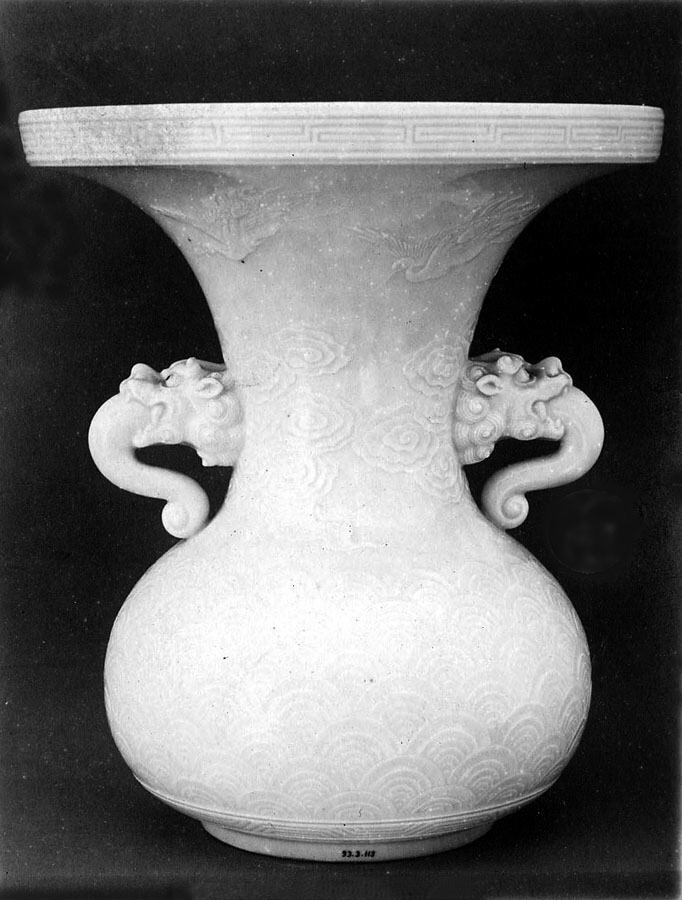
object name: vase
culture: japanese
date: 1780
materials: porcelain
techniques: carving